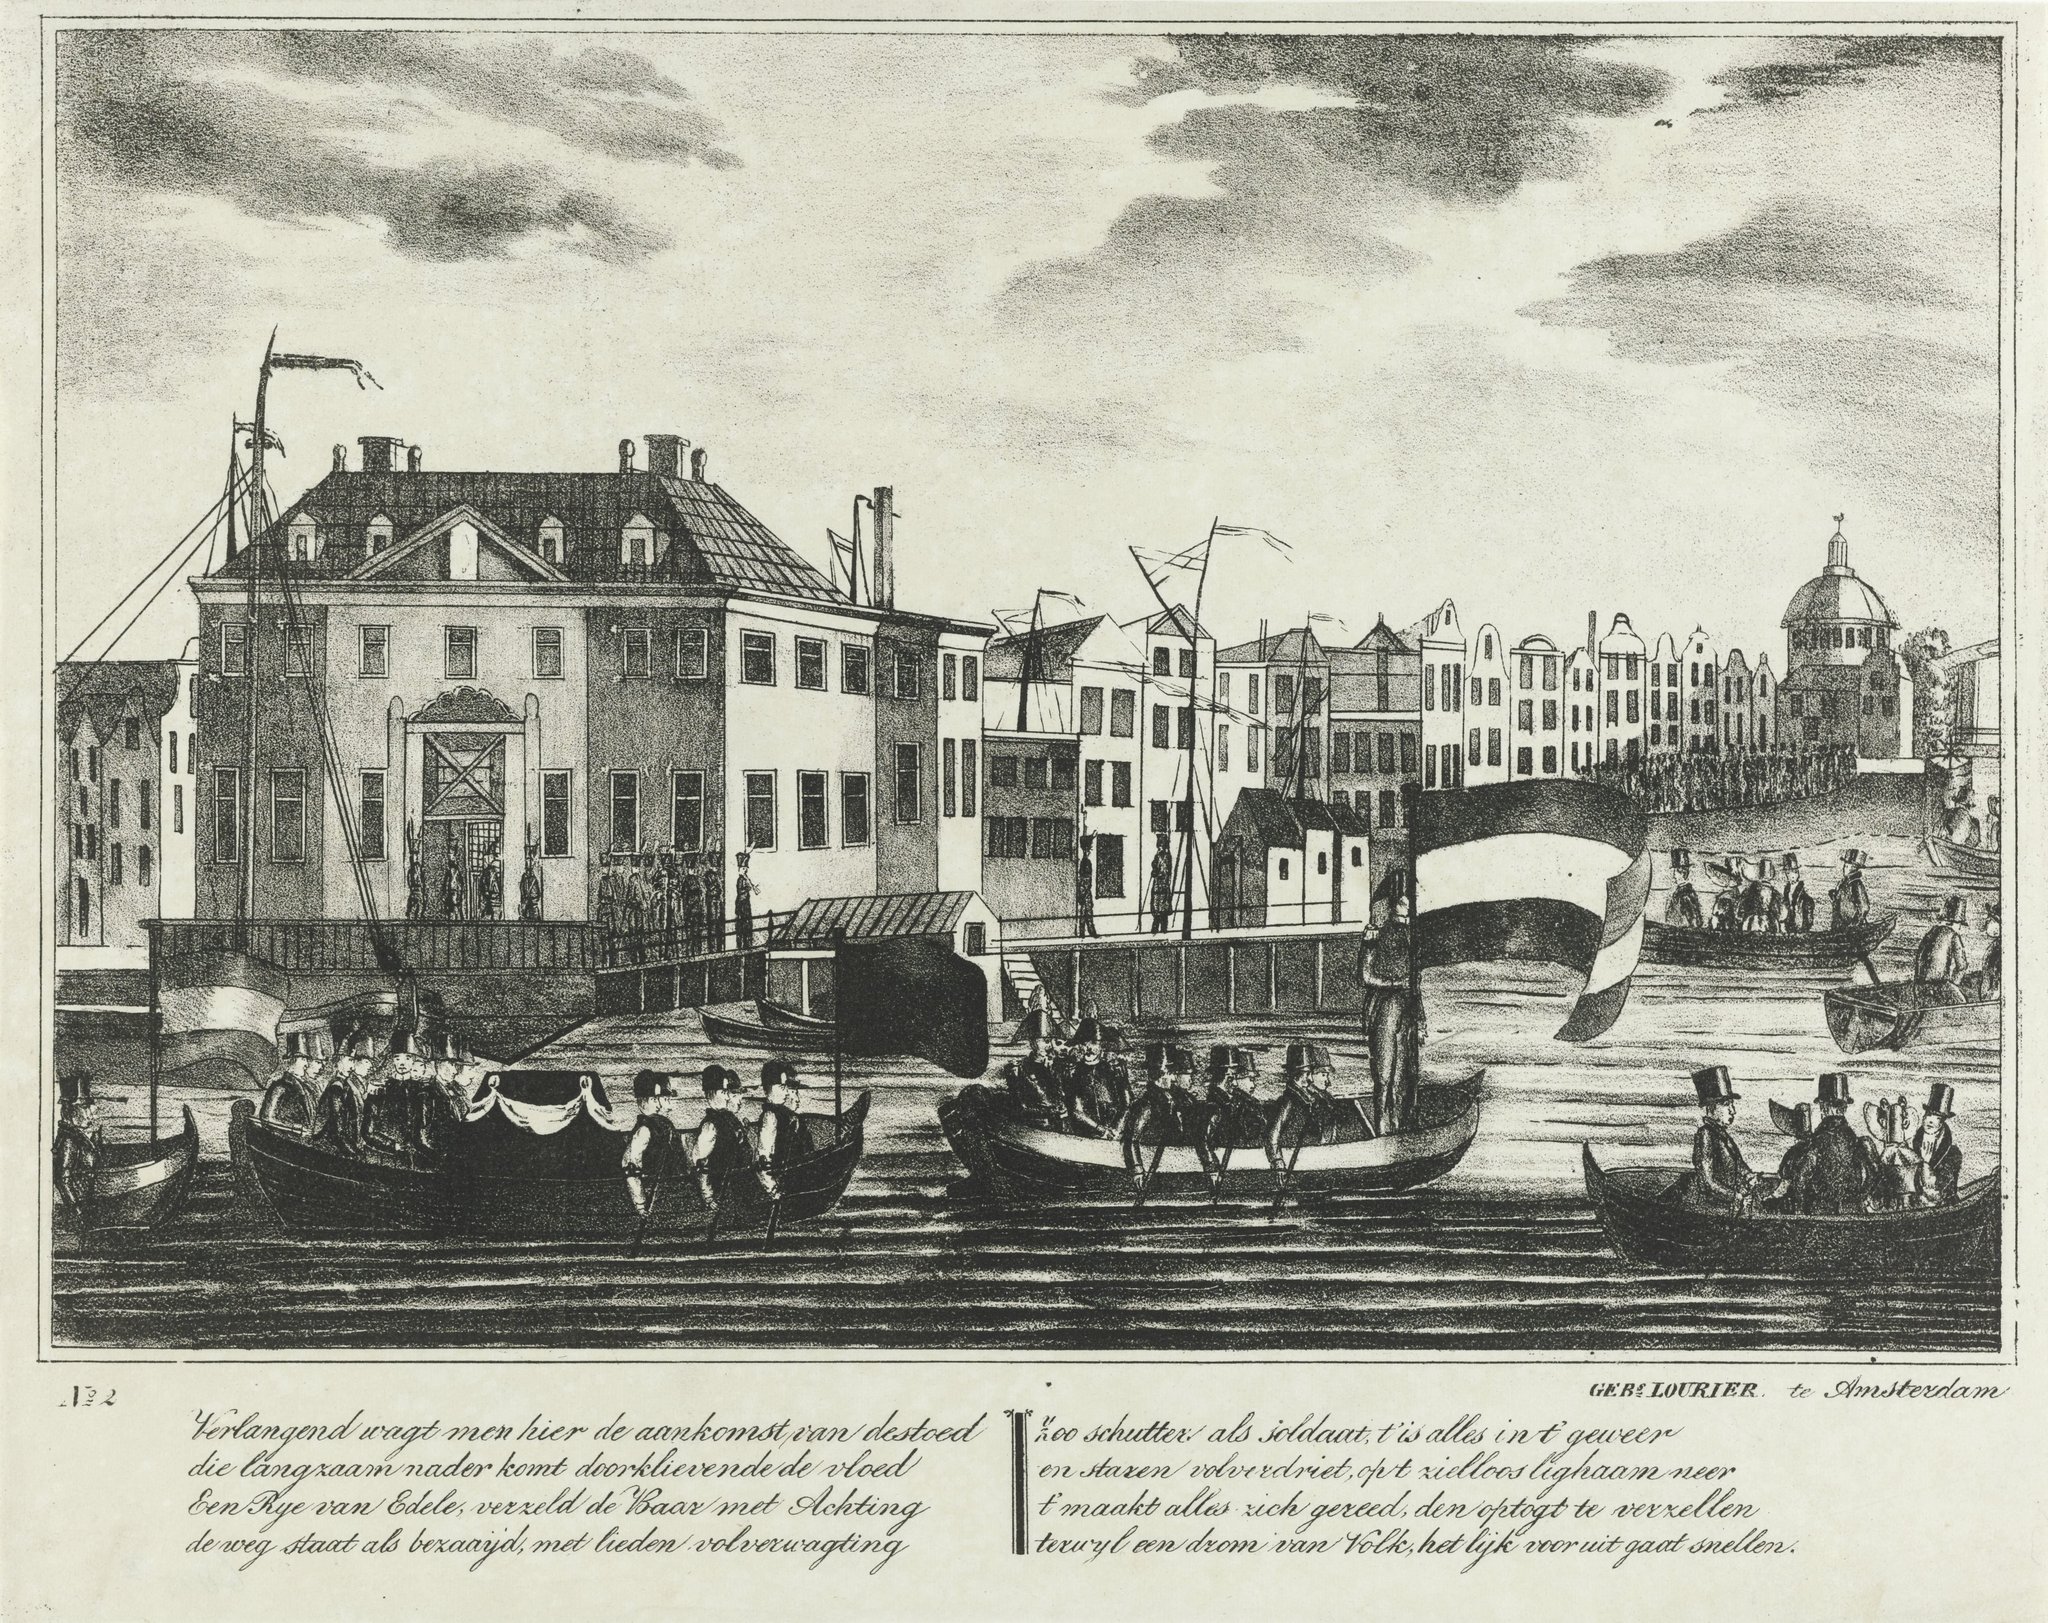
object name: print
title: Lijkvaart van Jan van Speyk langs de Nieuwe Stadsherberg, 1832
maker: Anonymous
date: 1832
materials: paper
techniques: lithograph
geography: amsterdam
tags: antwerp, jan van speyk, public funeral - aa - festivities on the water, cortege, funeral procession, amsterdam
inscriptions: collector's mark: Lugt 2228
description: De lijkvaart met de stoffelijke resten van Jan van Speyk vaart langs het gebouw van de Nieuwe Stadsherberg, Op het water enkele van acht kleine bootjes van de stoet en andere bootjes met toeschouwers. In het onderschrift twee vierregelige verzen. Tweede plaat in een serie van vier platen van de begrafenis van Jan van Speyk te Amsterdam op 4 met 1832.